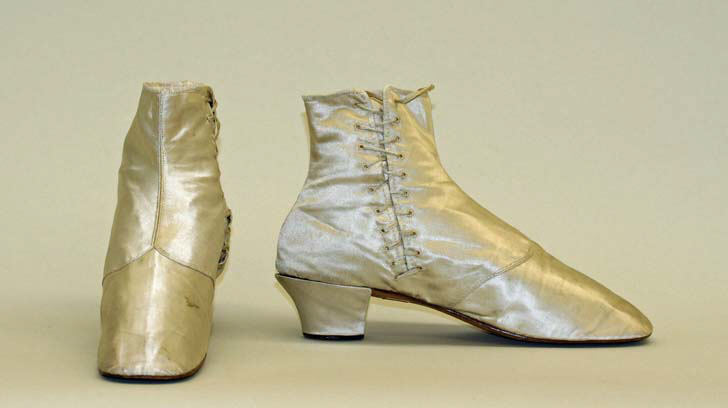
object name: boot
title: Boots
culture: european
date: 1850-1860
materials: cotton, leather, silk